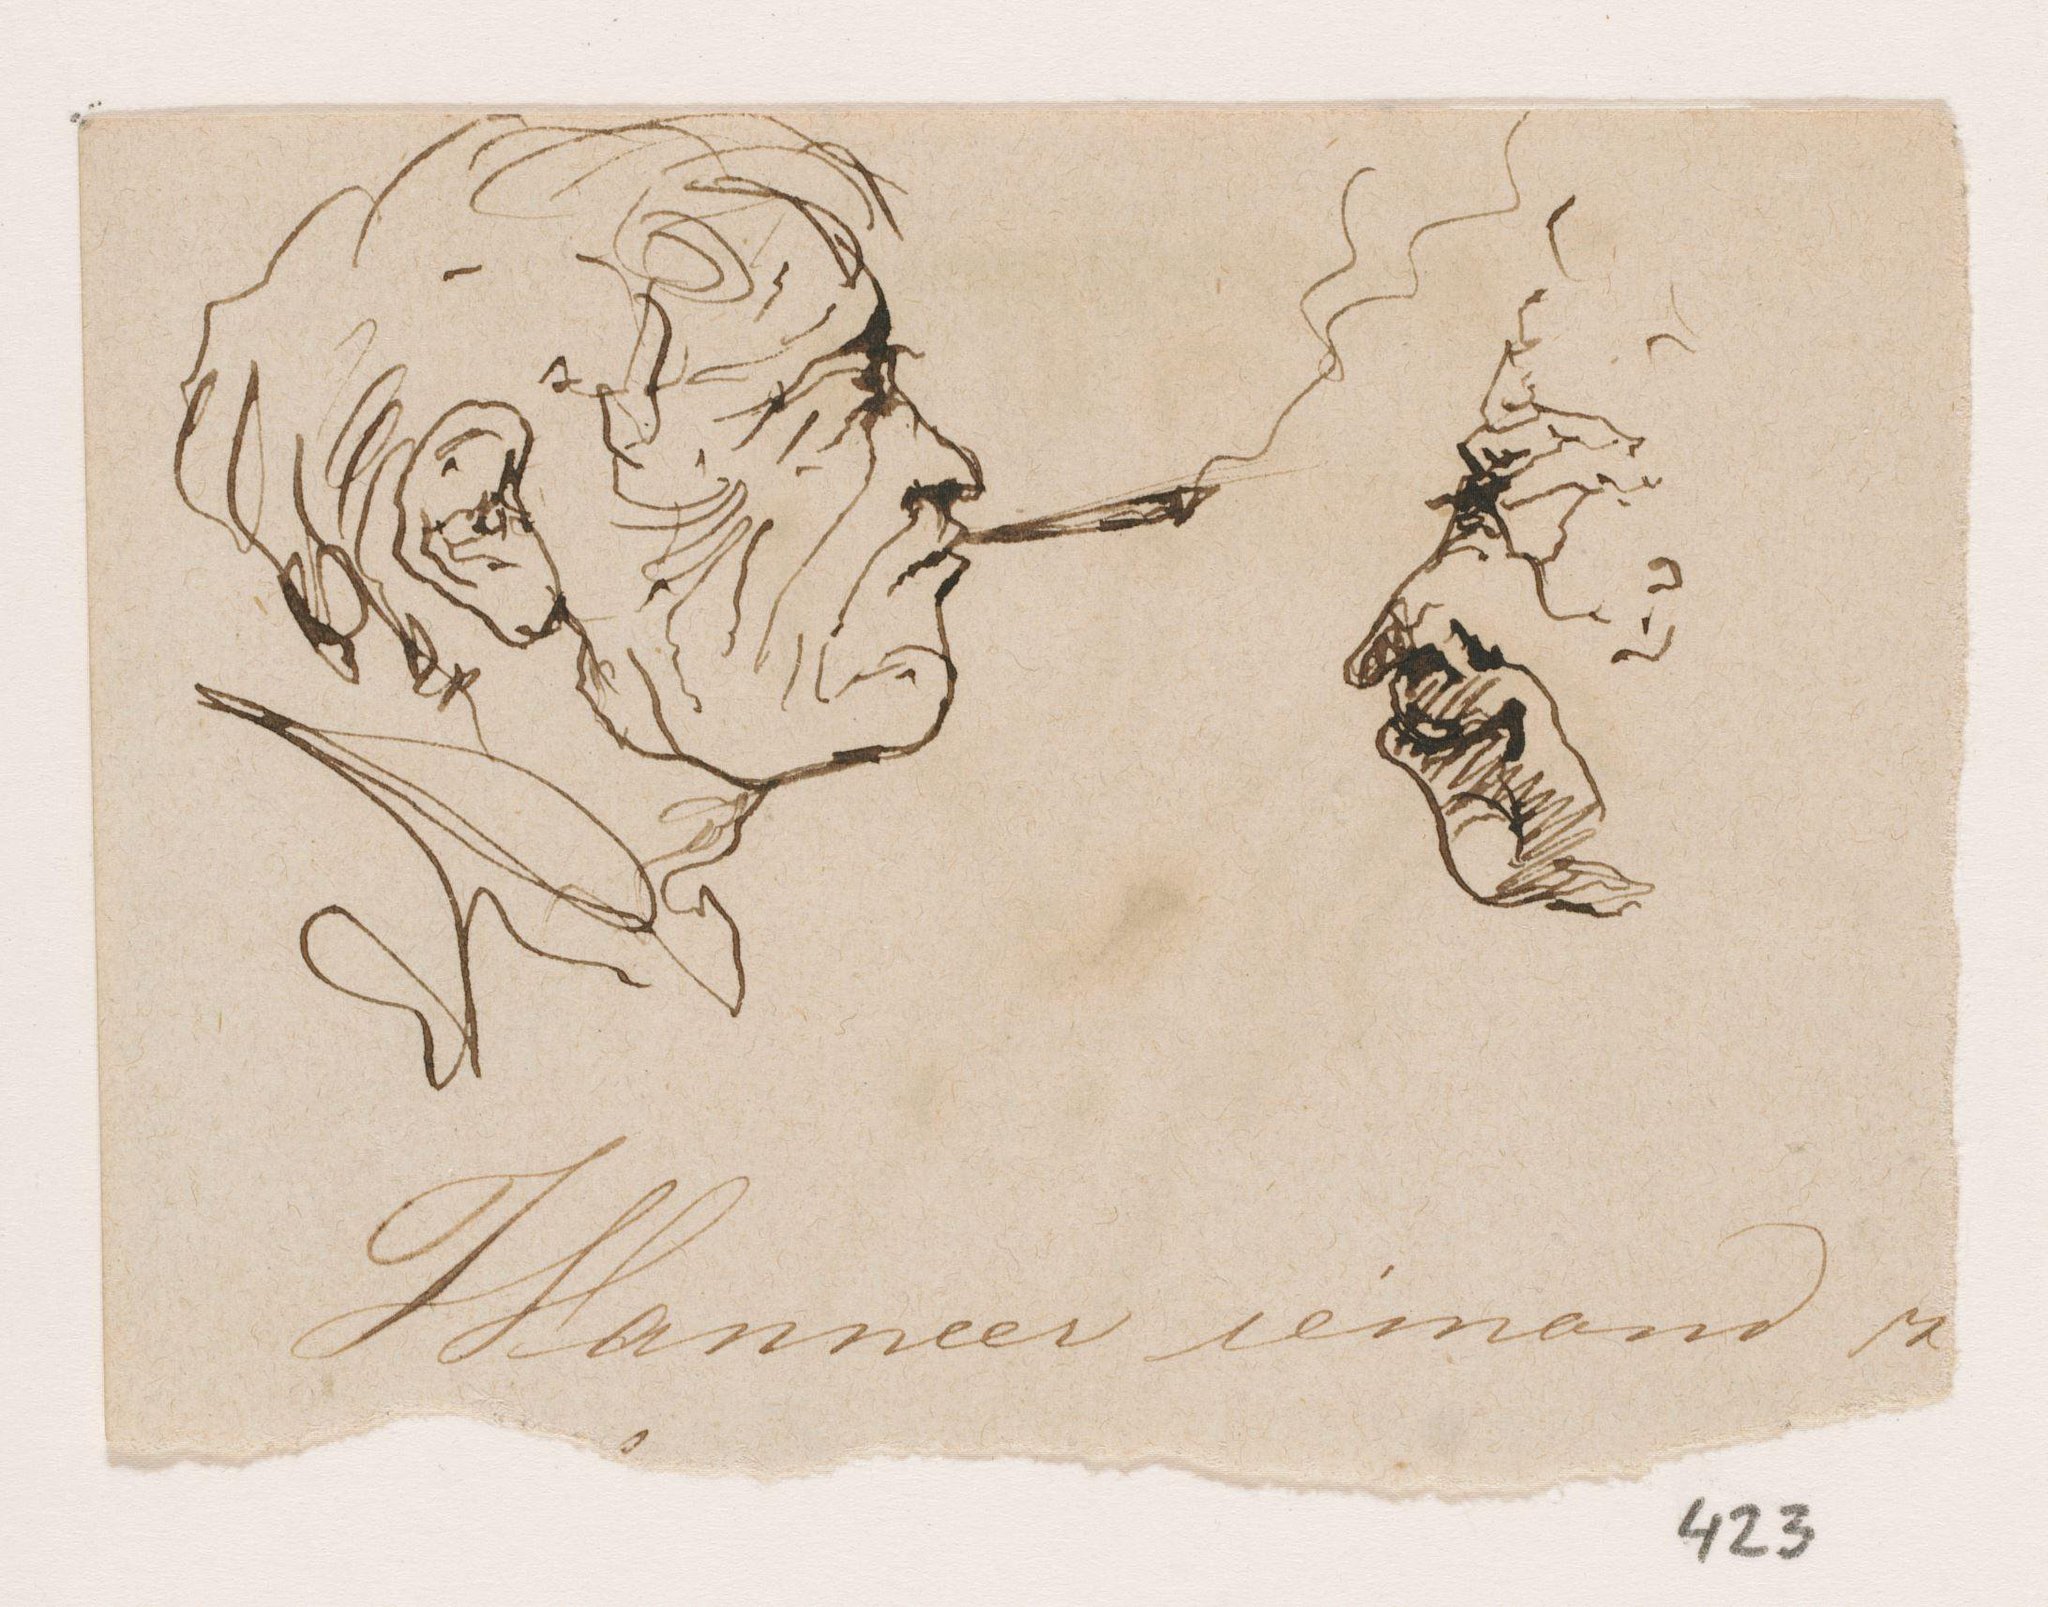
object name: drawing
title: Man met sigaret en kop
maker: johannes tavenraat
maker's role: draughtsman, painter, print maker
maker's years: 1809-1881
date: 1840-1880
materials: ink, paper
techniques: pen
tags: cigarette, caricatures (human types)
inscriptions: collector's mark: Lugt 2228